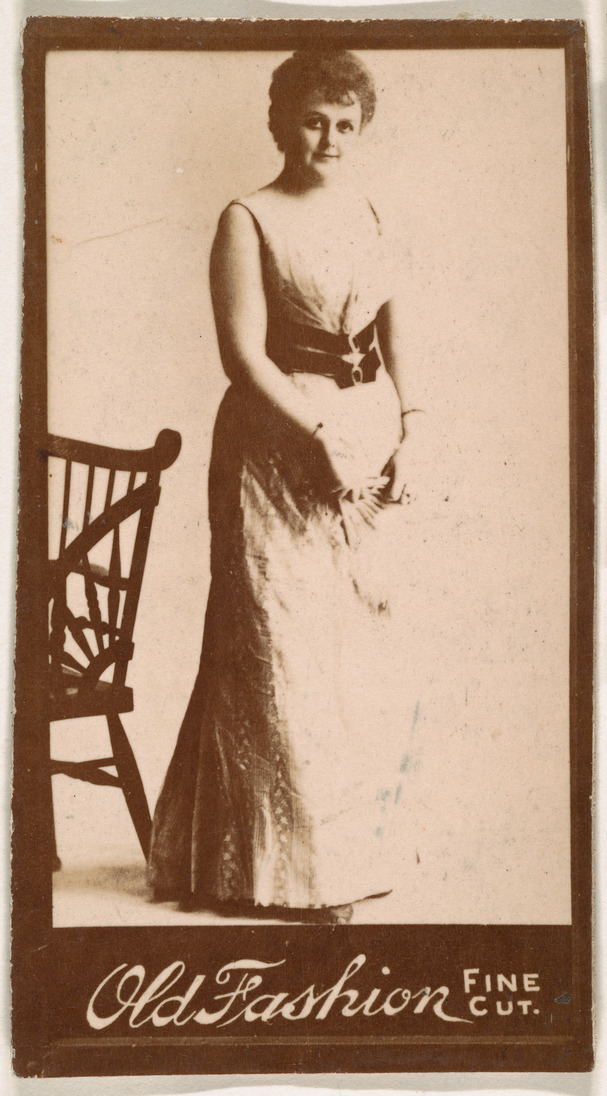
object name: photograph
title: Actress standing next to chair, from the Actresses series (N664) promoting Old Fashion Fine Cut Tobacco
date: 1888-1890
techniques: albumen silver print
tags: portraits,women,actresses